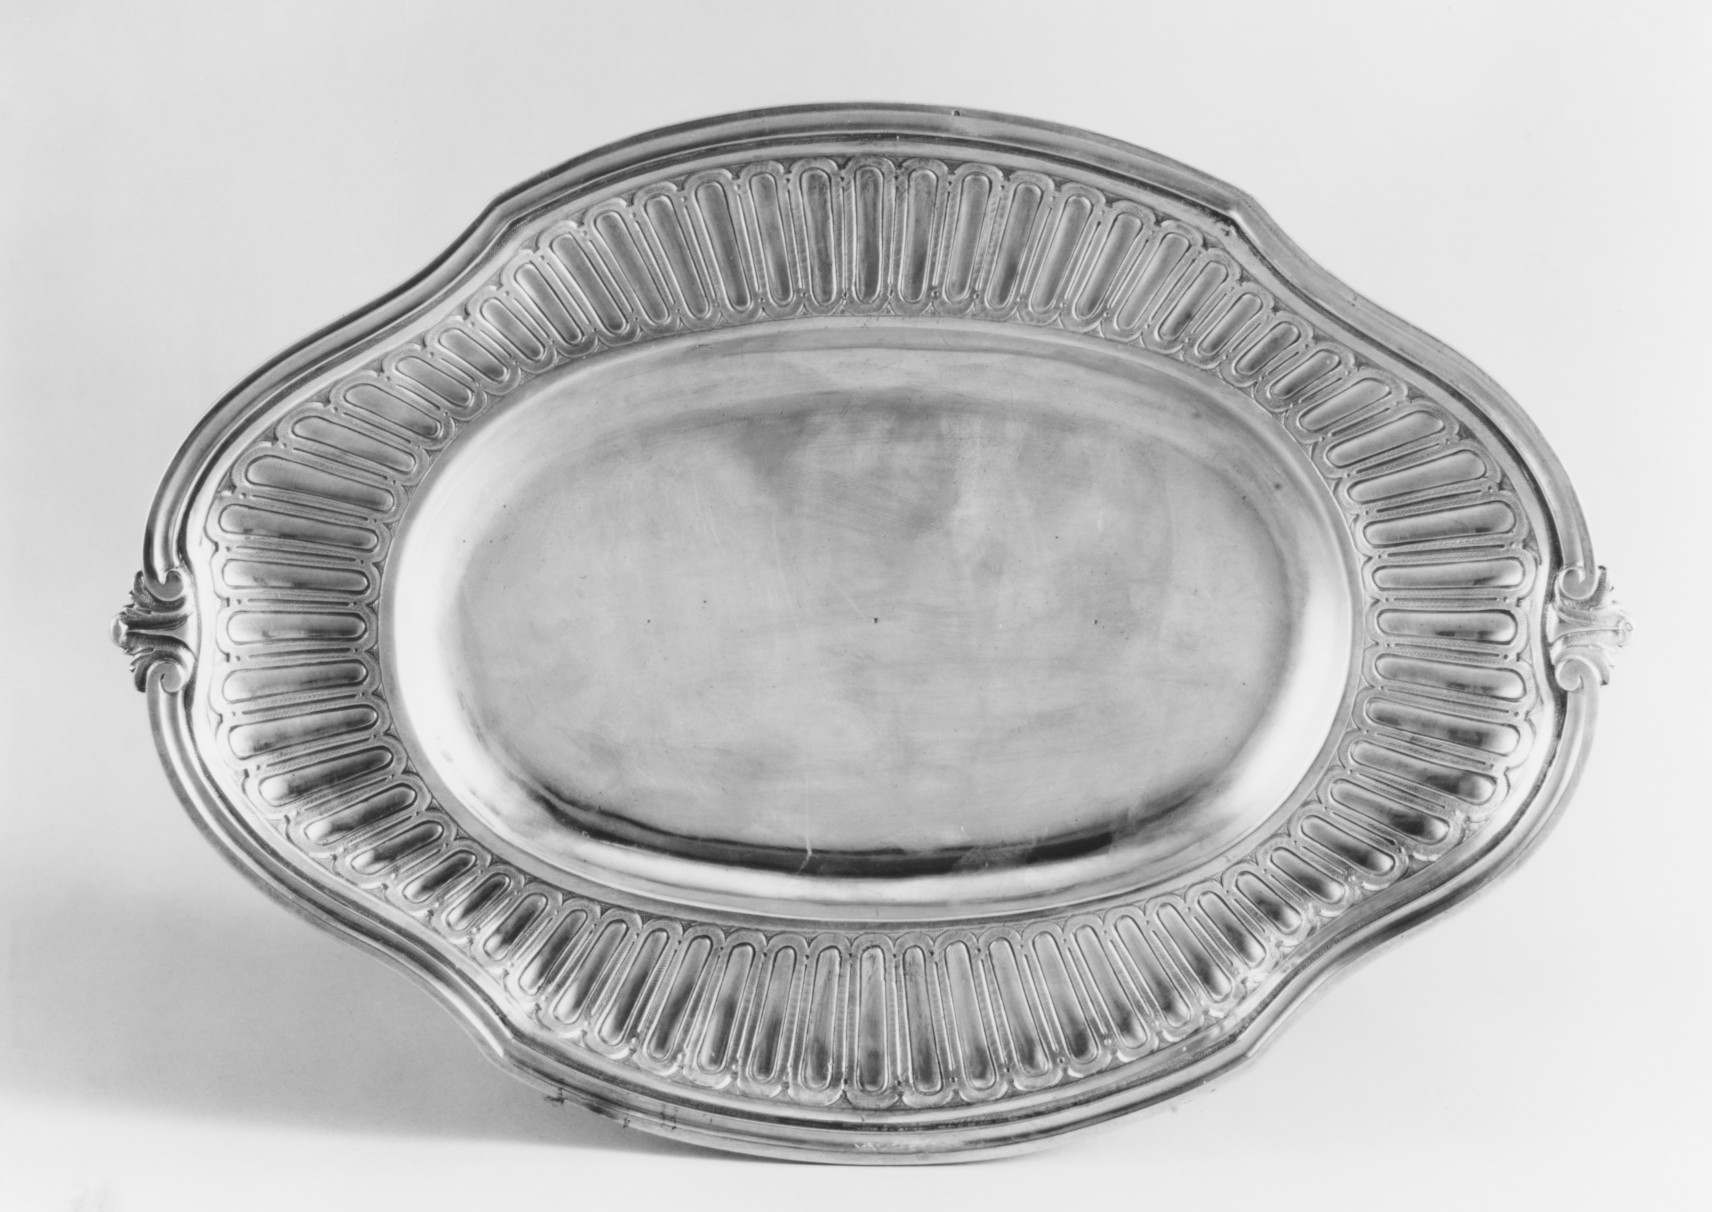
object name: tray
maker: jacques favre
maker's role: maker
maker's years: 1744-1823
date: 1783-1784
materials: silver